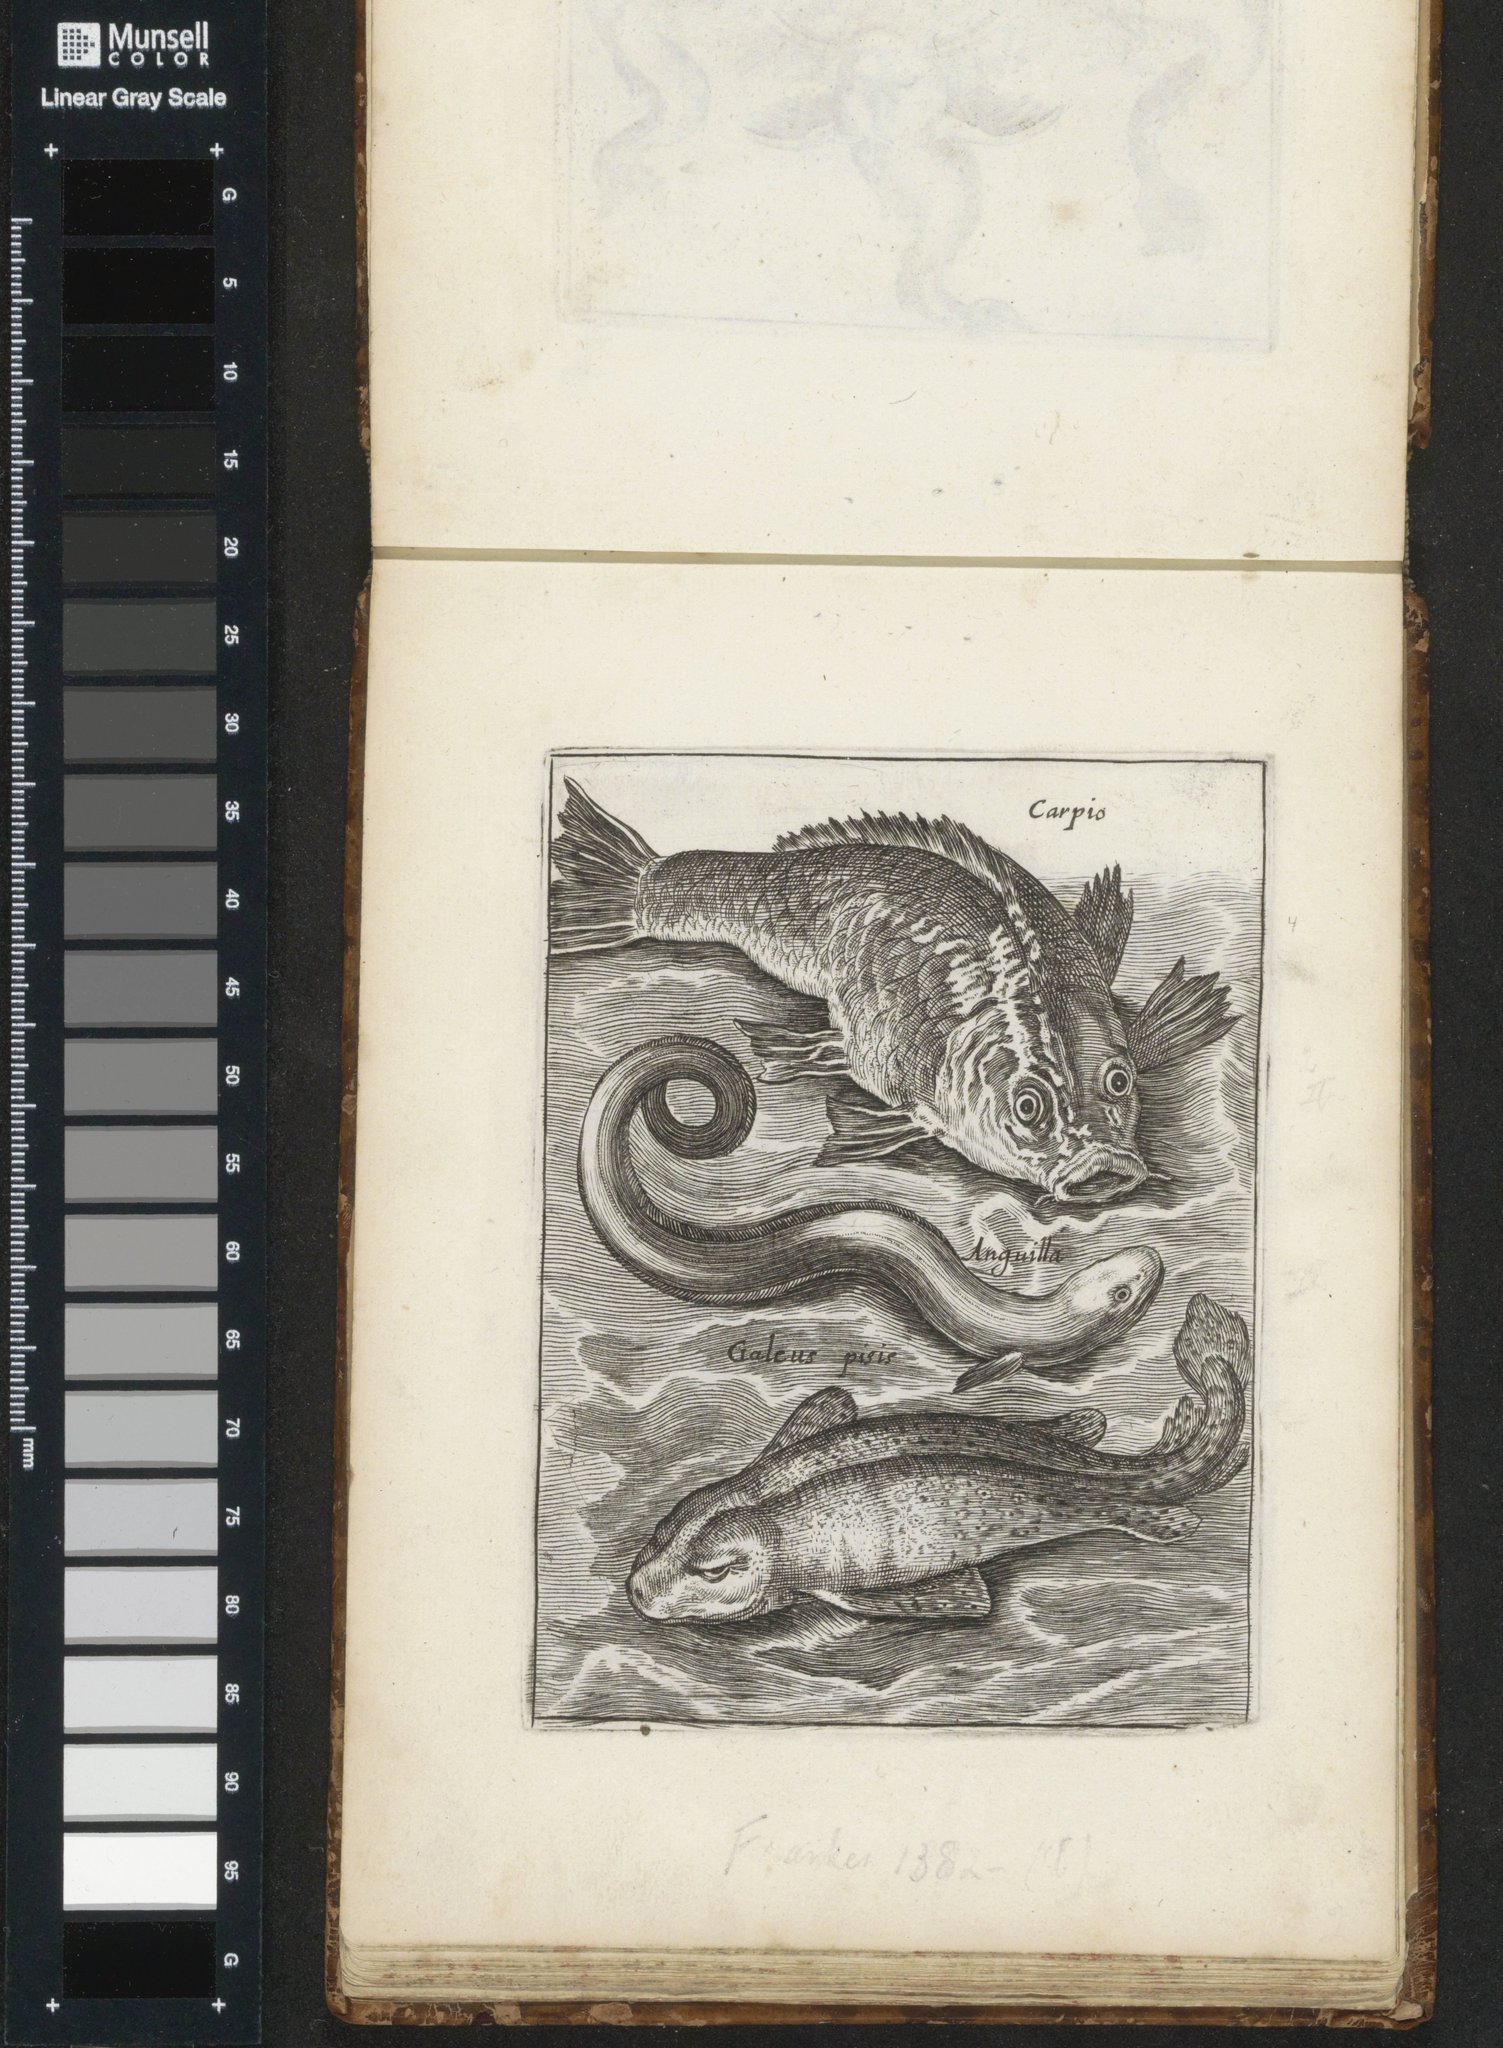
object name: print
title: Karper, paling en hondshaai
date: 1635-1660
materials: paper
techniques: engraving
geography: utrecht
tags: eels, bony fishes: carp, cartilaginous fishes: dogfish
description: Karper, paling en hondshaai. Bij iedere vis de naam in het Latijn. Deze prent maakt deel uit van een album.